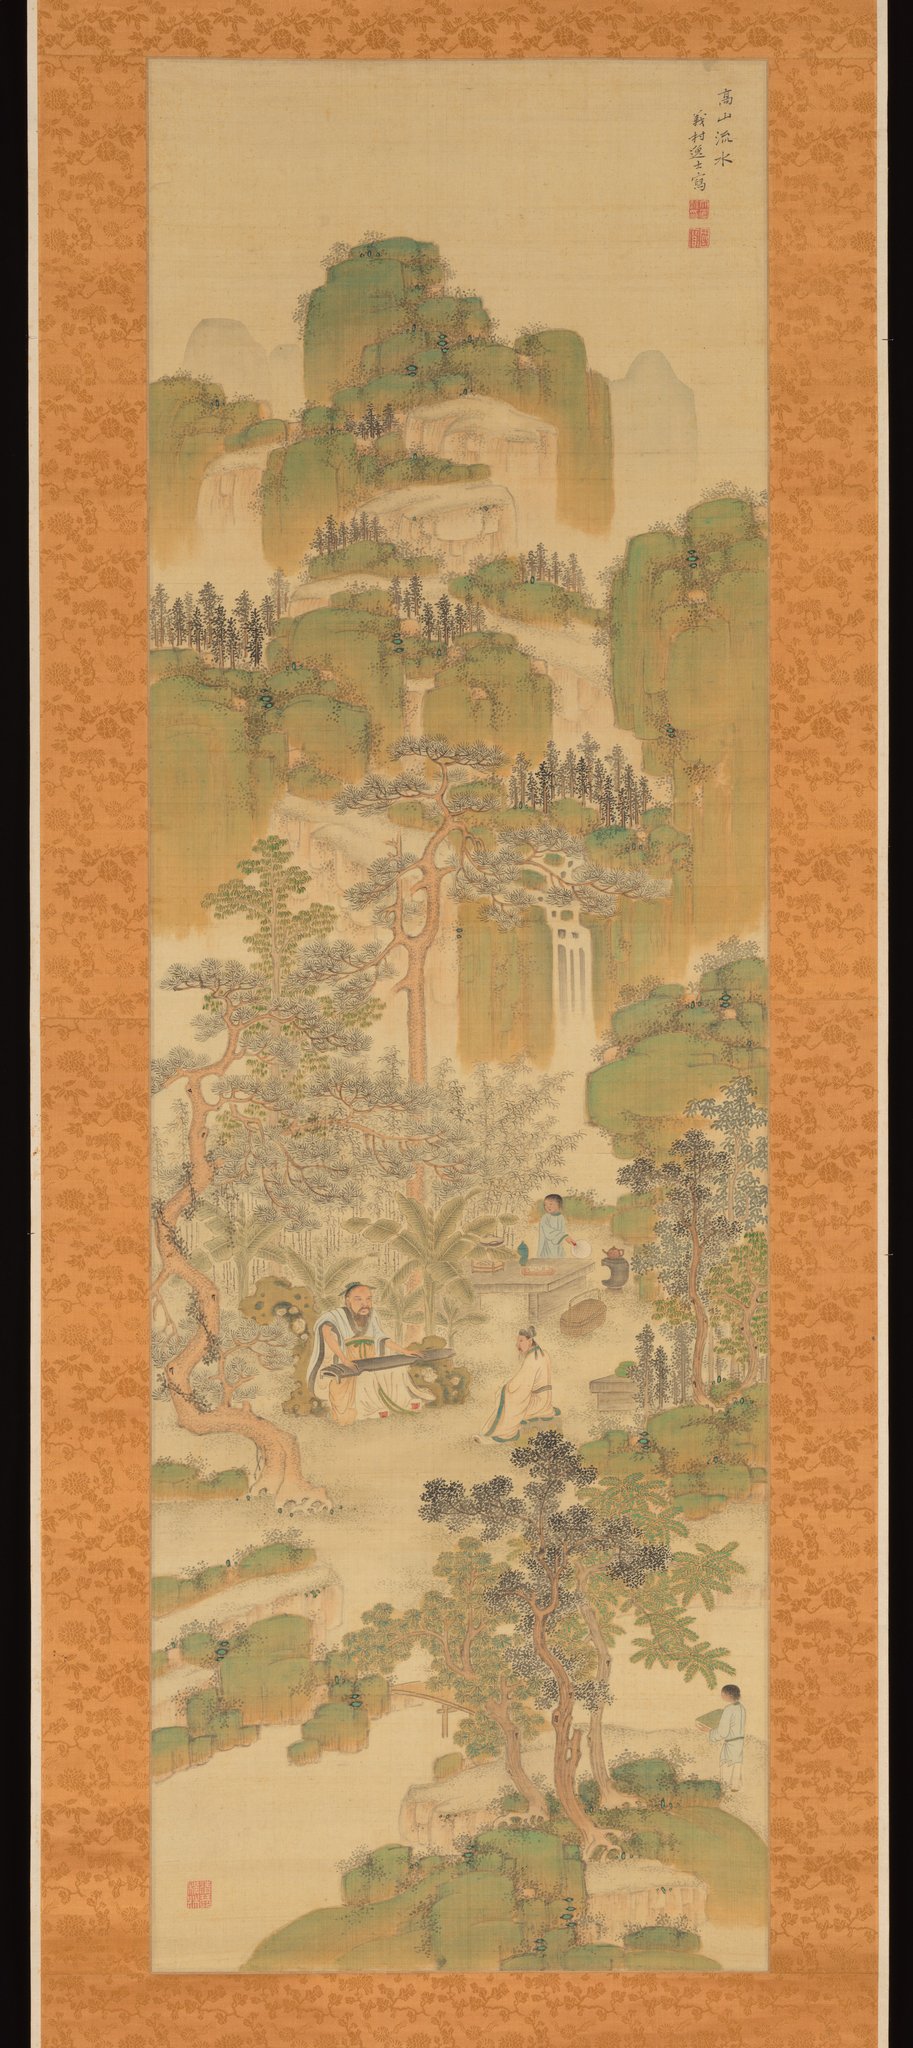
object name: hanging scroll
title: High Mountains, Flowing Water: Yu Boya and Zhong Ziqi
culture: japanese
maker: okura ryūzan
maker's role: artist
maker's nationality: japanese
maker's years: 1785-1850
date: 1840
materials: ink, silk